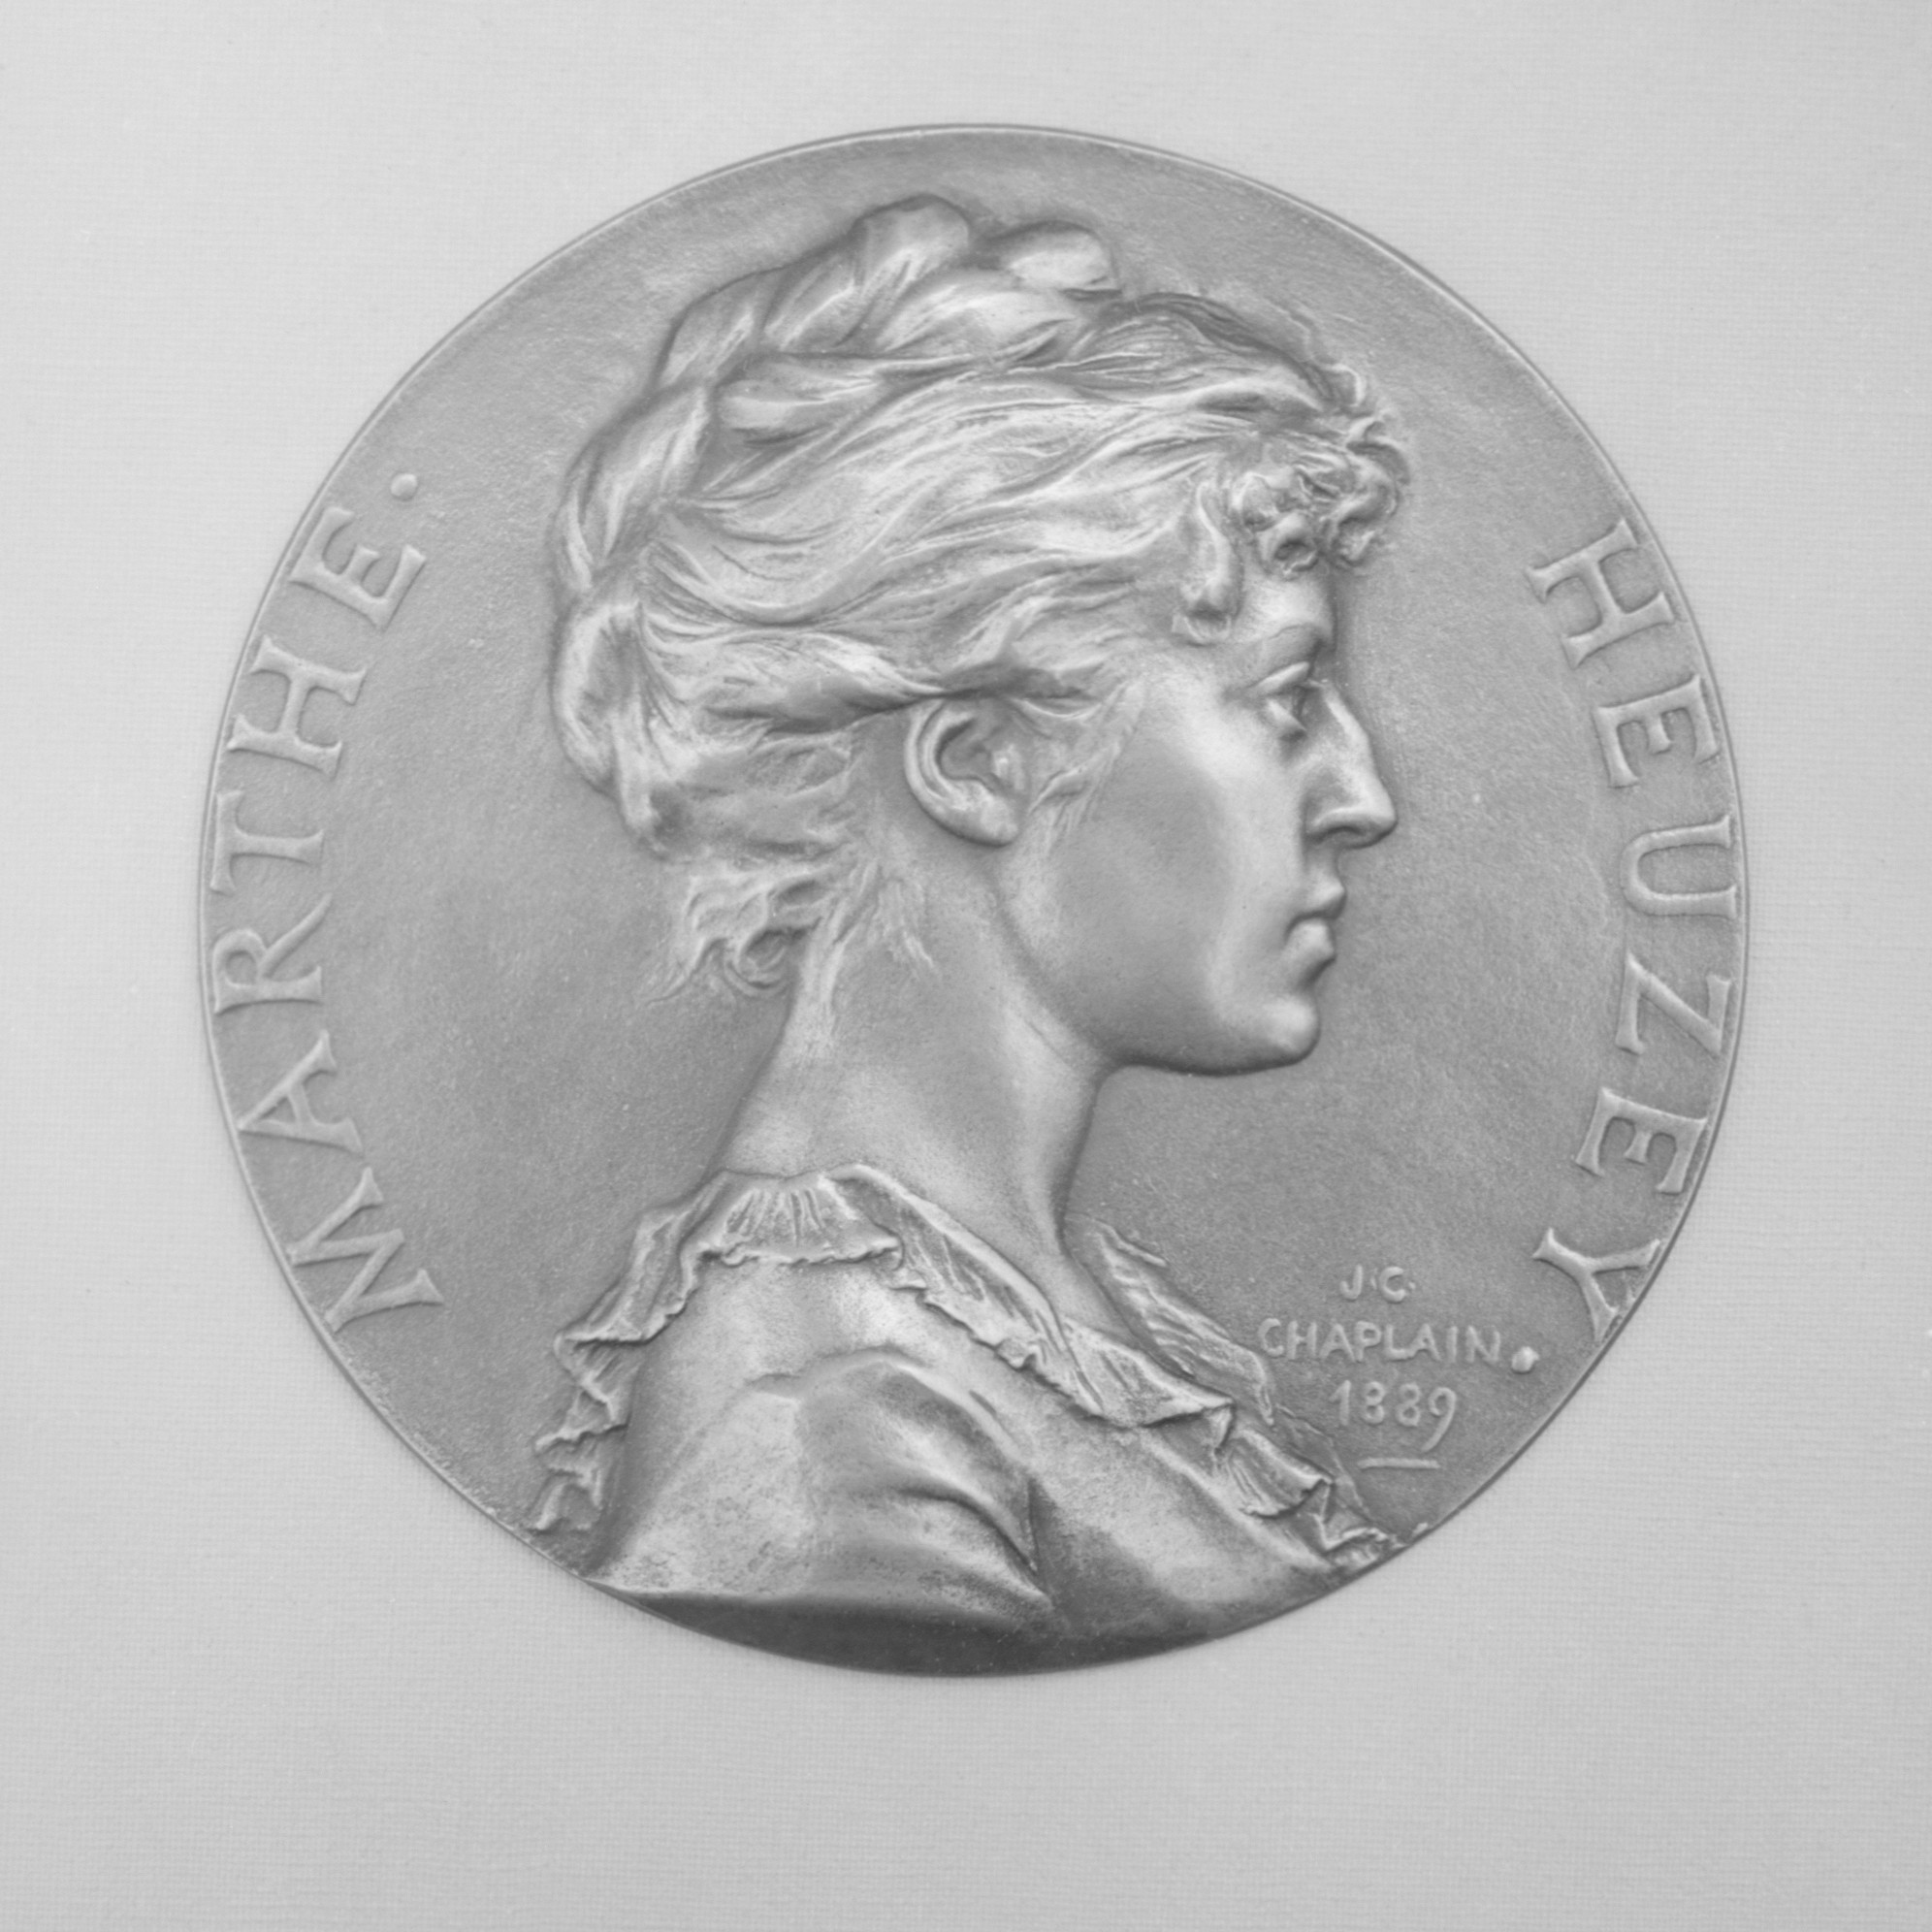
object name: medallion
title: Portrait of Mlle. Heuzey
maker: jules-clément chaplain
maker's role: artist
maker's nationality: french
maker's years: 1839-1909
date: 1889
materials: bronze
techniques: casting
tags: portraits,women